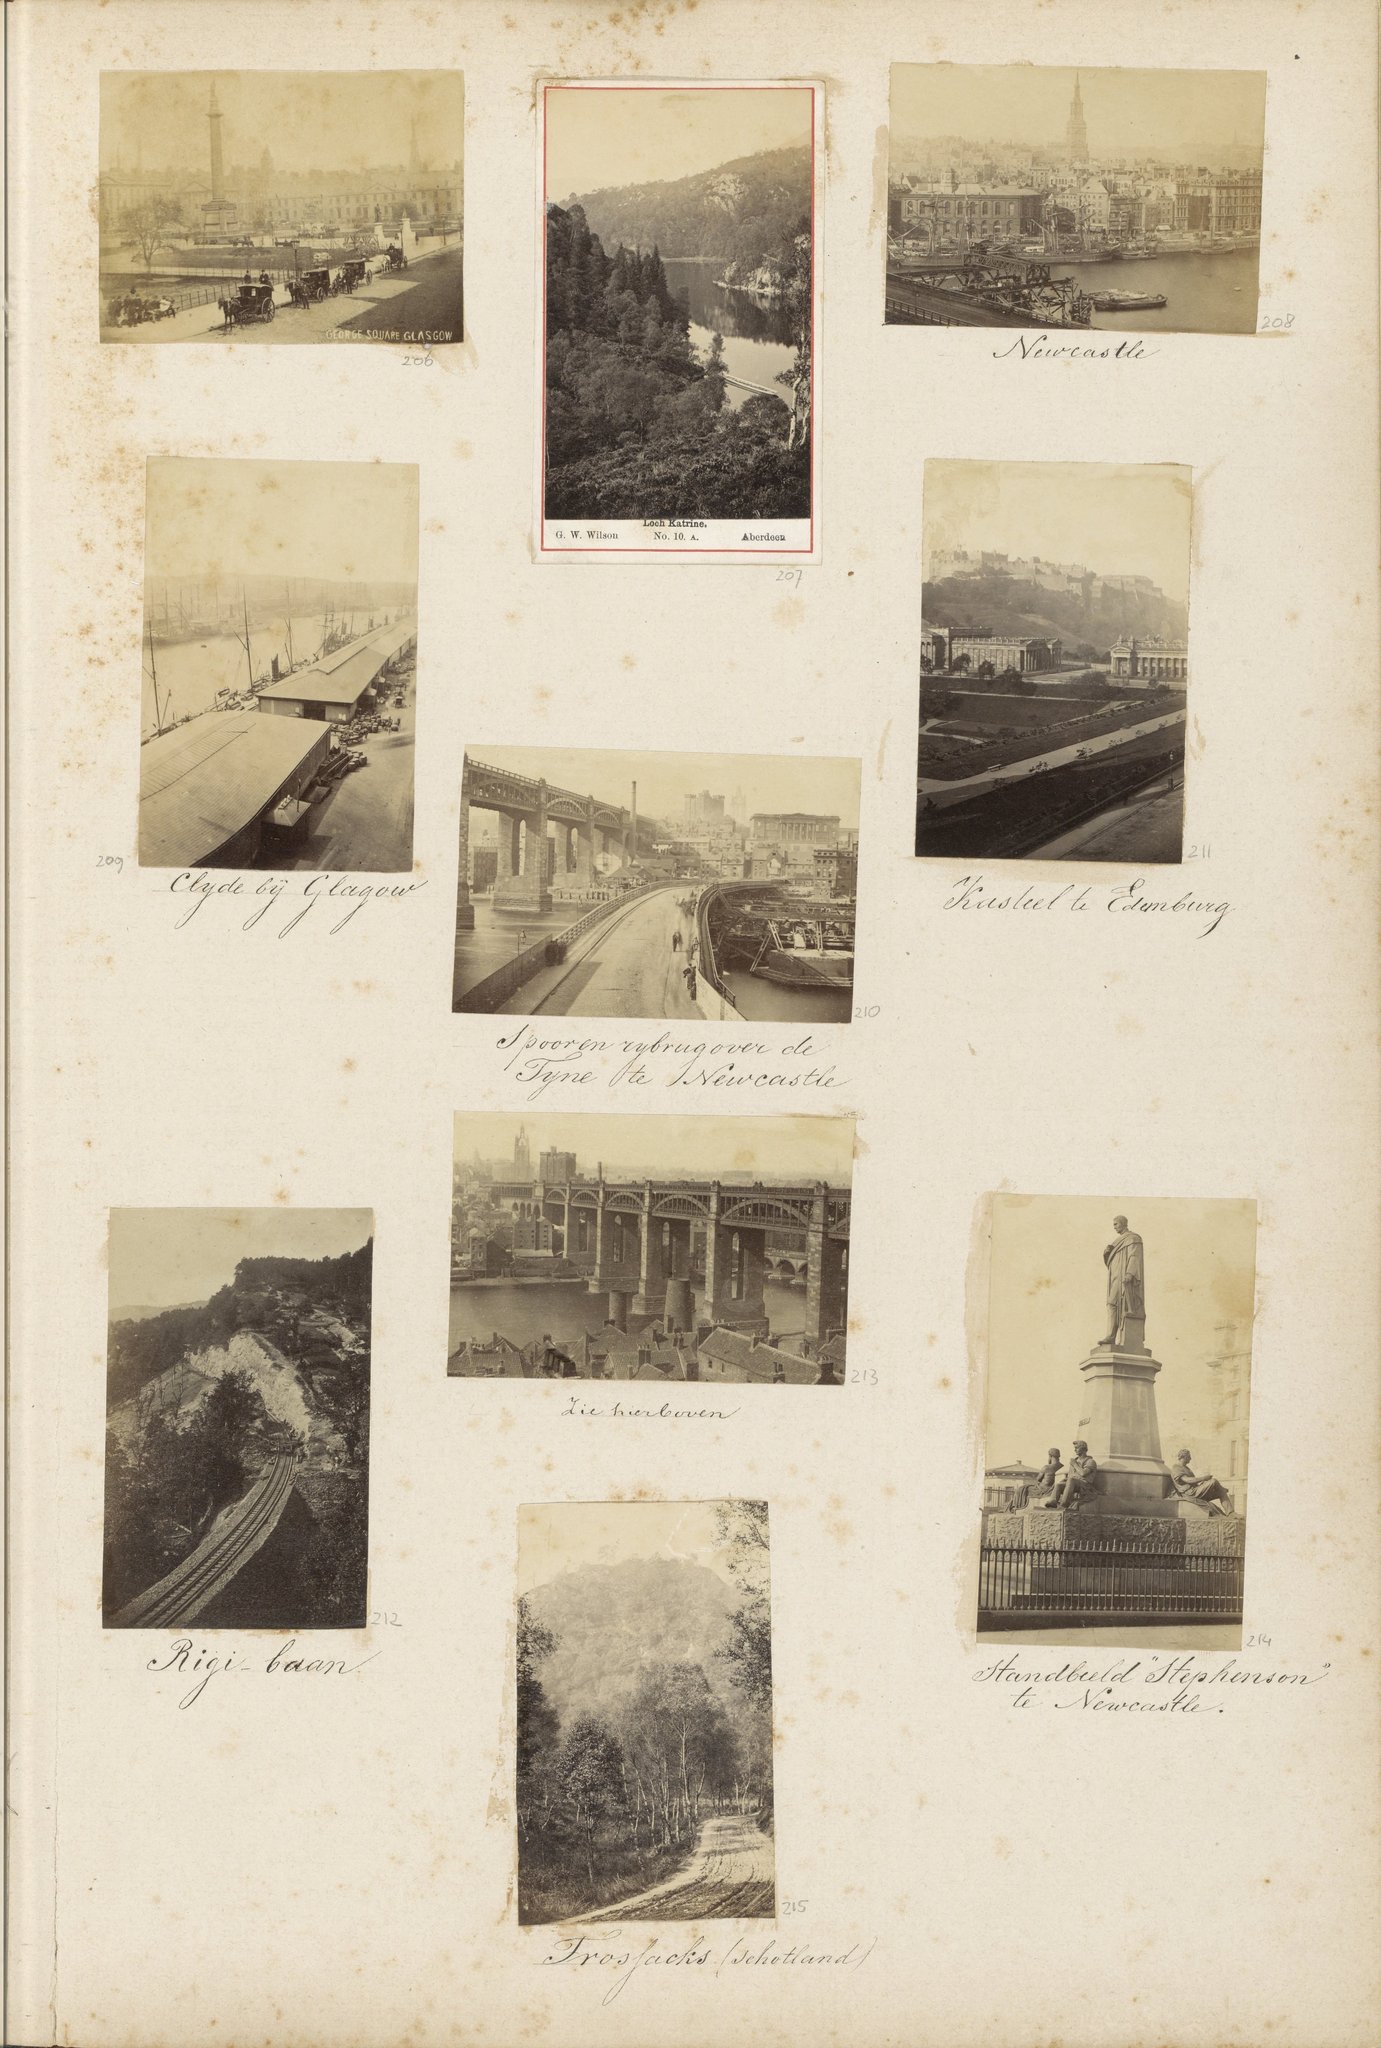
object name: album leaf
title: George Square Glasgow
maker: Anonymous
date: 1870-1880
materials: paper, photographic support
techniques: albumen print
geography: glasgow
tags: animal traction, animal-drawn vehicle (carriage etc.), column, pillar ~ architecture, square, place, circus, etc. (+ city(-scape) with figures, staffage), glasgow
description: Onderdeel van Fotoalbum van Robert Daniel Crommelin (1841-1907).